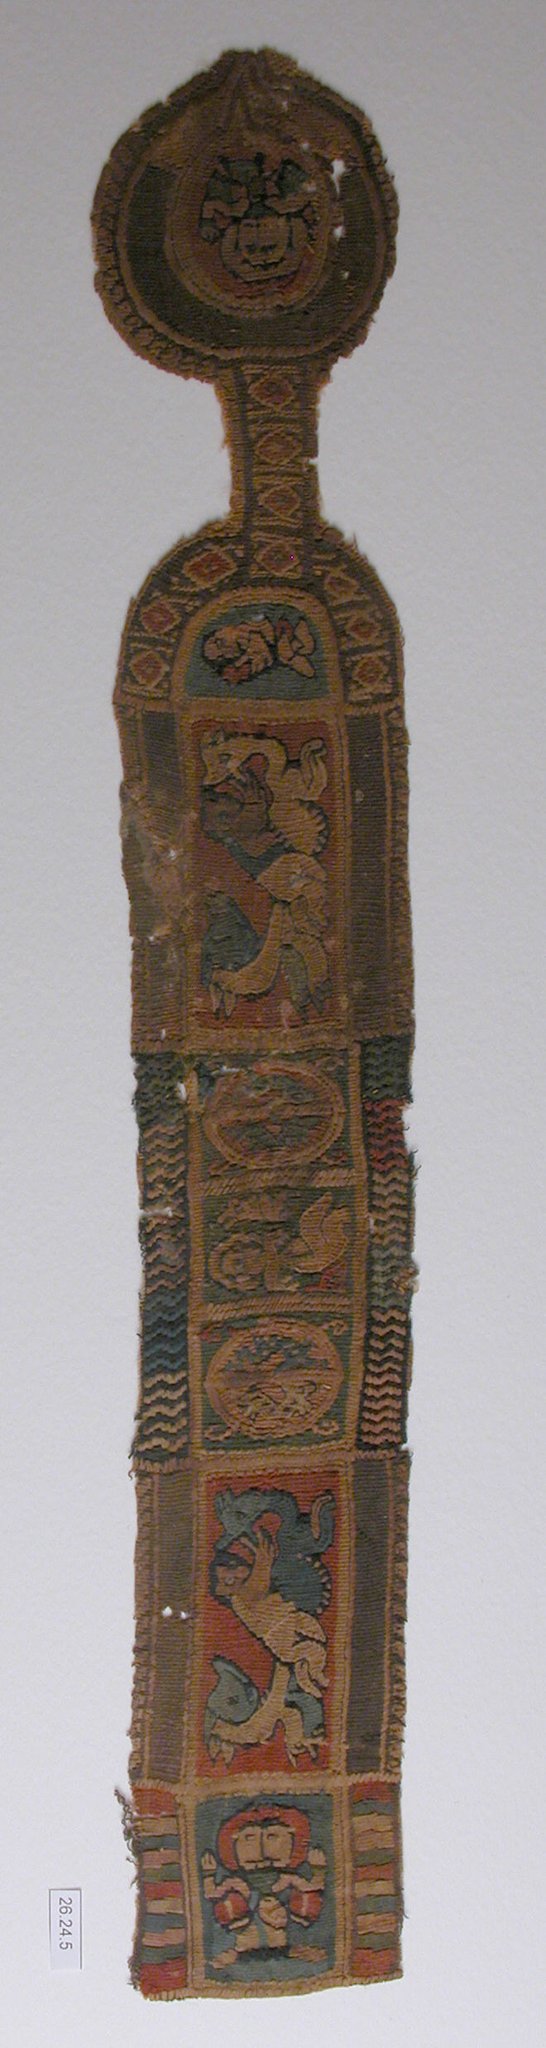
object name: shoulder band fragment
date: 401-600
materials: wool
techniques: weave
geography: egypt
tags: mythical creatures